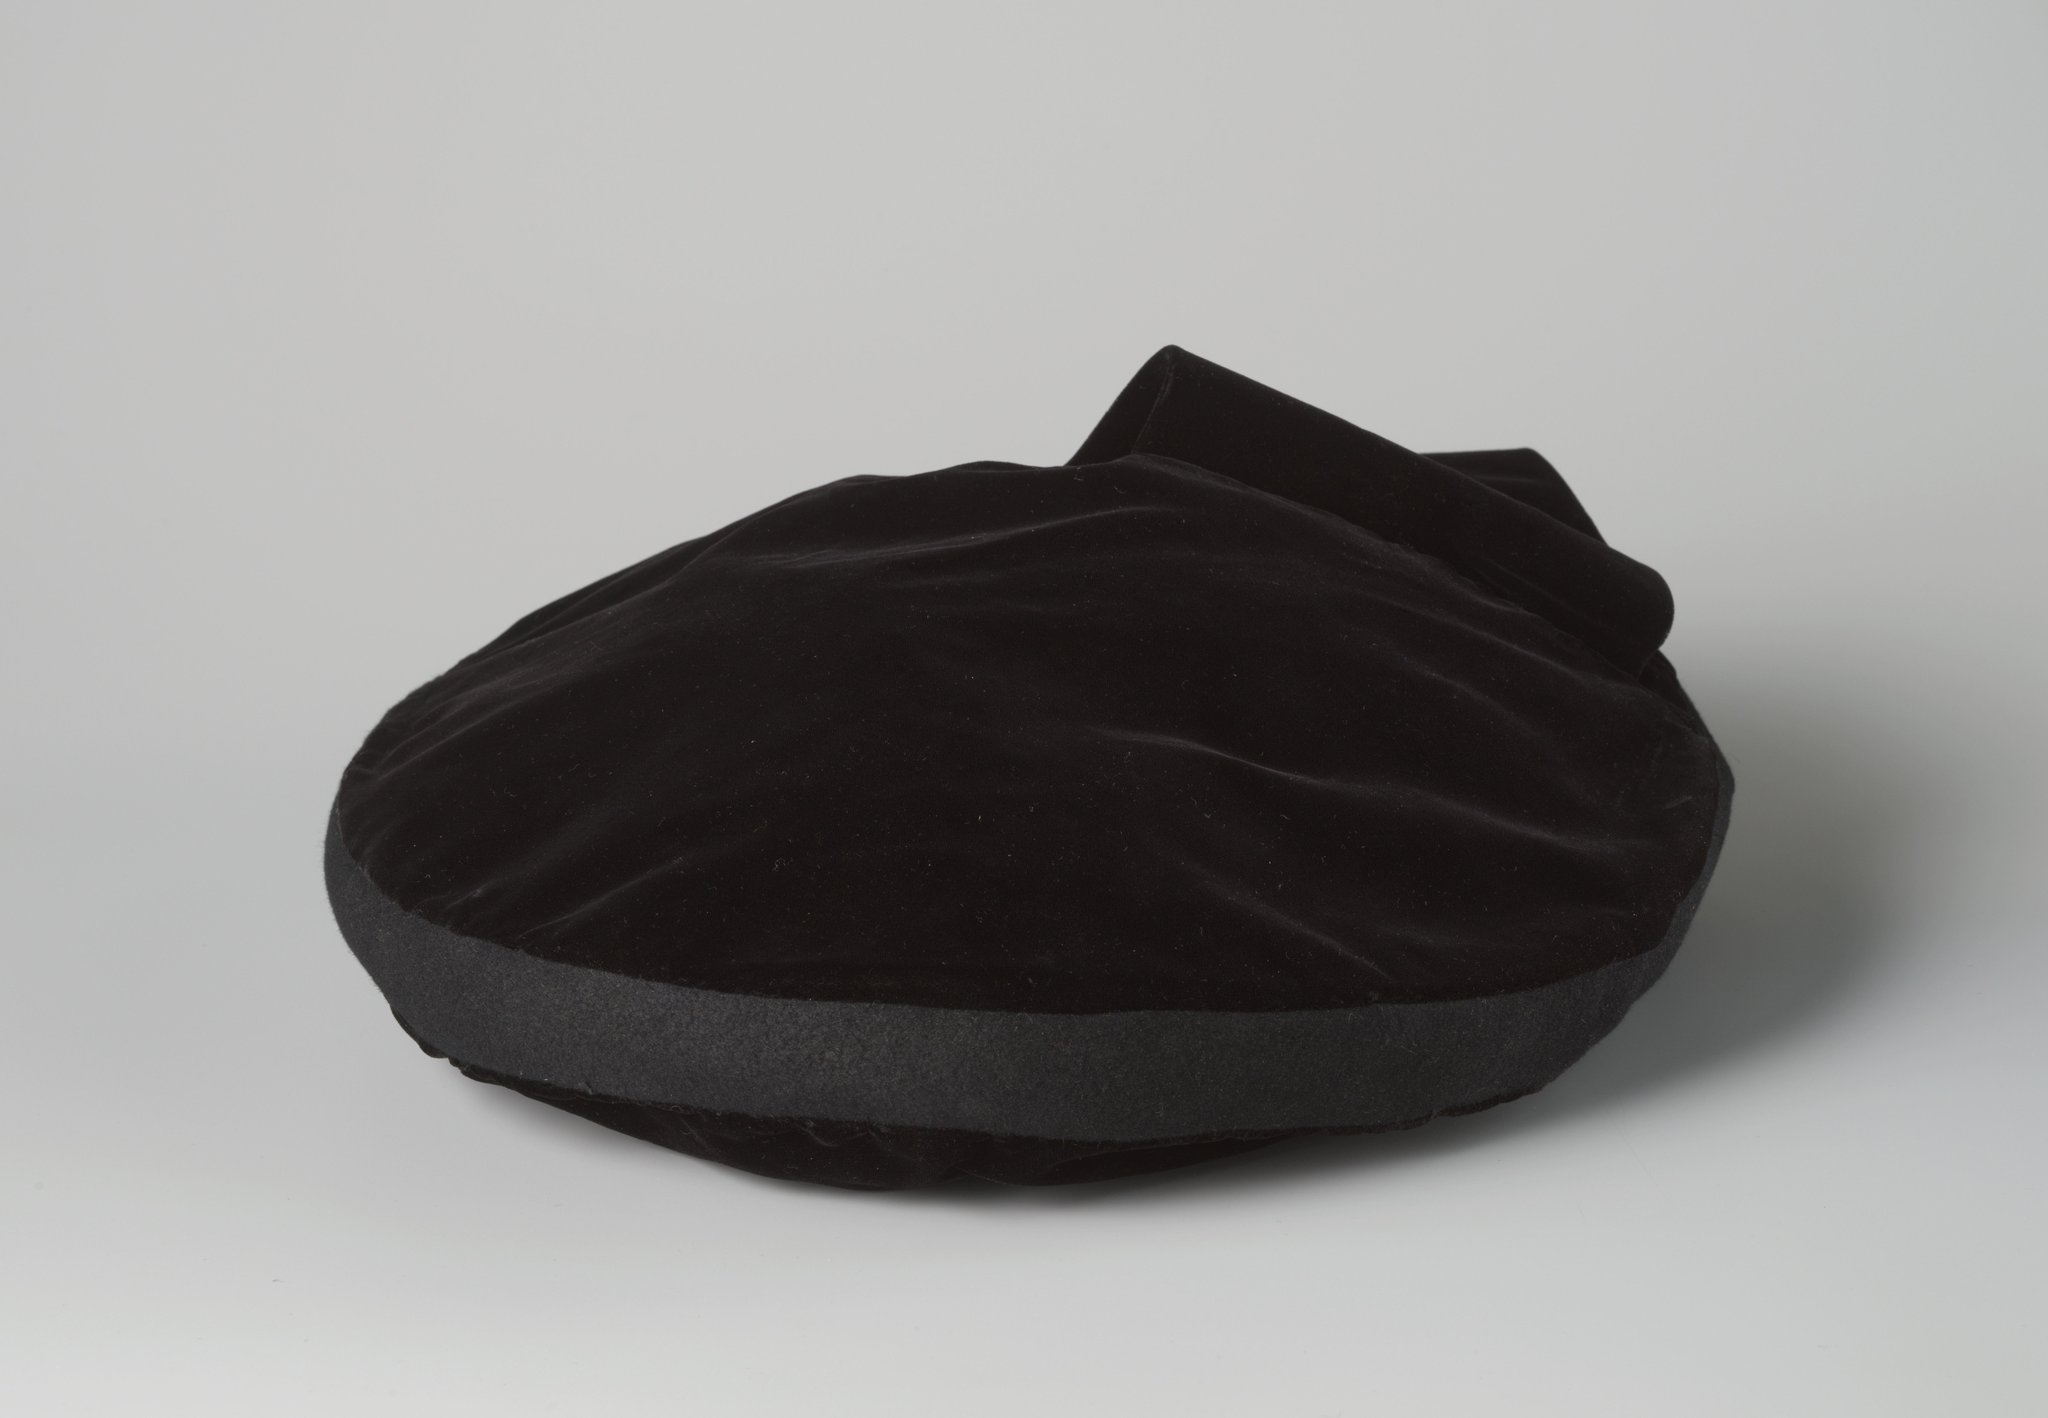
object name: womenswear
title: Hoed van zwart fluweel in baret model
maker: Anonymous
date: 1942-1949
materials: felt, metal, velvet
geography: koog aan de zaan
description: Hoed van zwart fluweel. Hoog opstaand, plat, baretmodel van twee fluwelen op elkaar genaaide cirkels met een zwarte viltstreep op de naad. Met een laiton gevuld. Het bovenstuk is in een platte kegelvorm dichtgenaaid. Het onderstuk is aan een vilten hoofdband genaaid. Op het bovenstuk is bij de kegelnaad een breed band zwart bandfluweel opgenaaid. Hierover een zwart machinale kantlus. Voor bijbehorende japon zie: BK-1973-378.